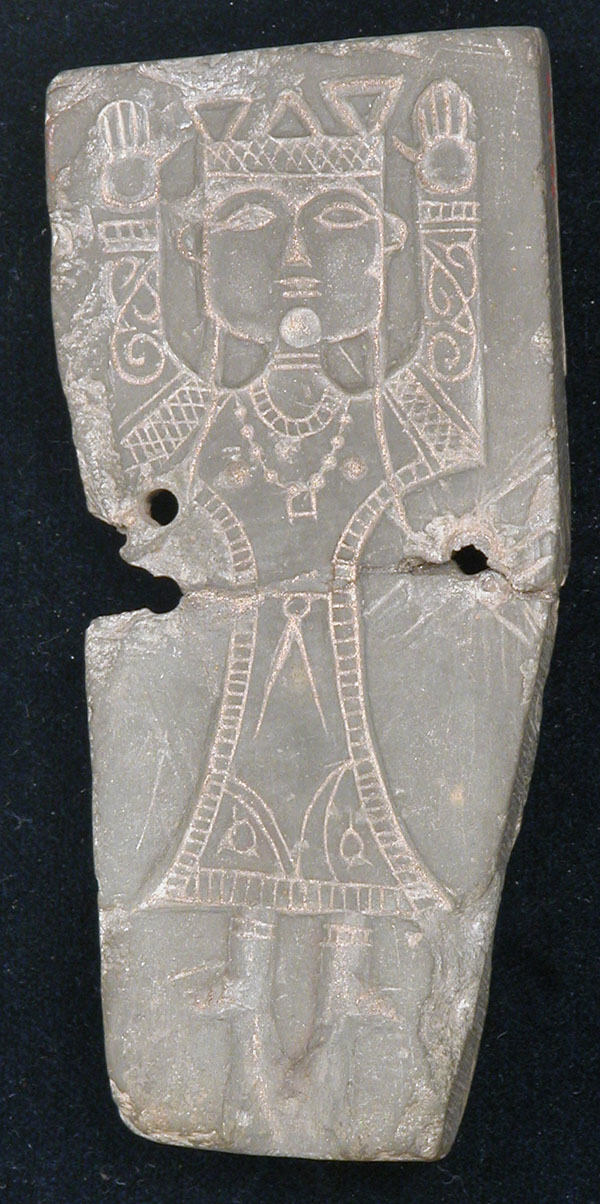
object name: mold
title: Mold for Making Gold Placques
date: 901-1200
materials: earthenware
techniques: molding, relief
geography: iran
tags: human figures